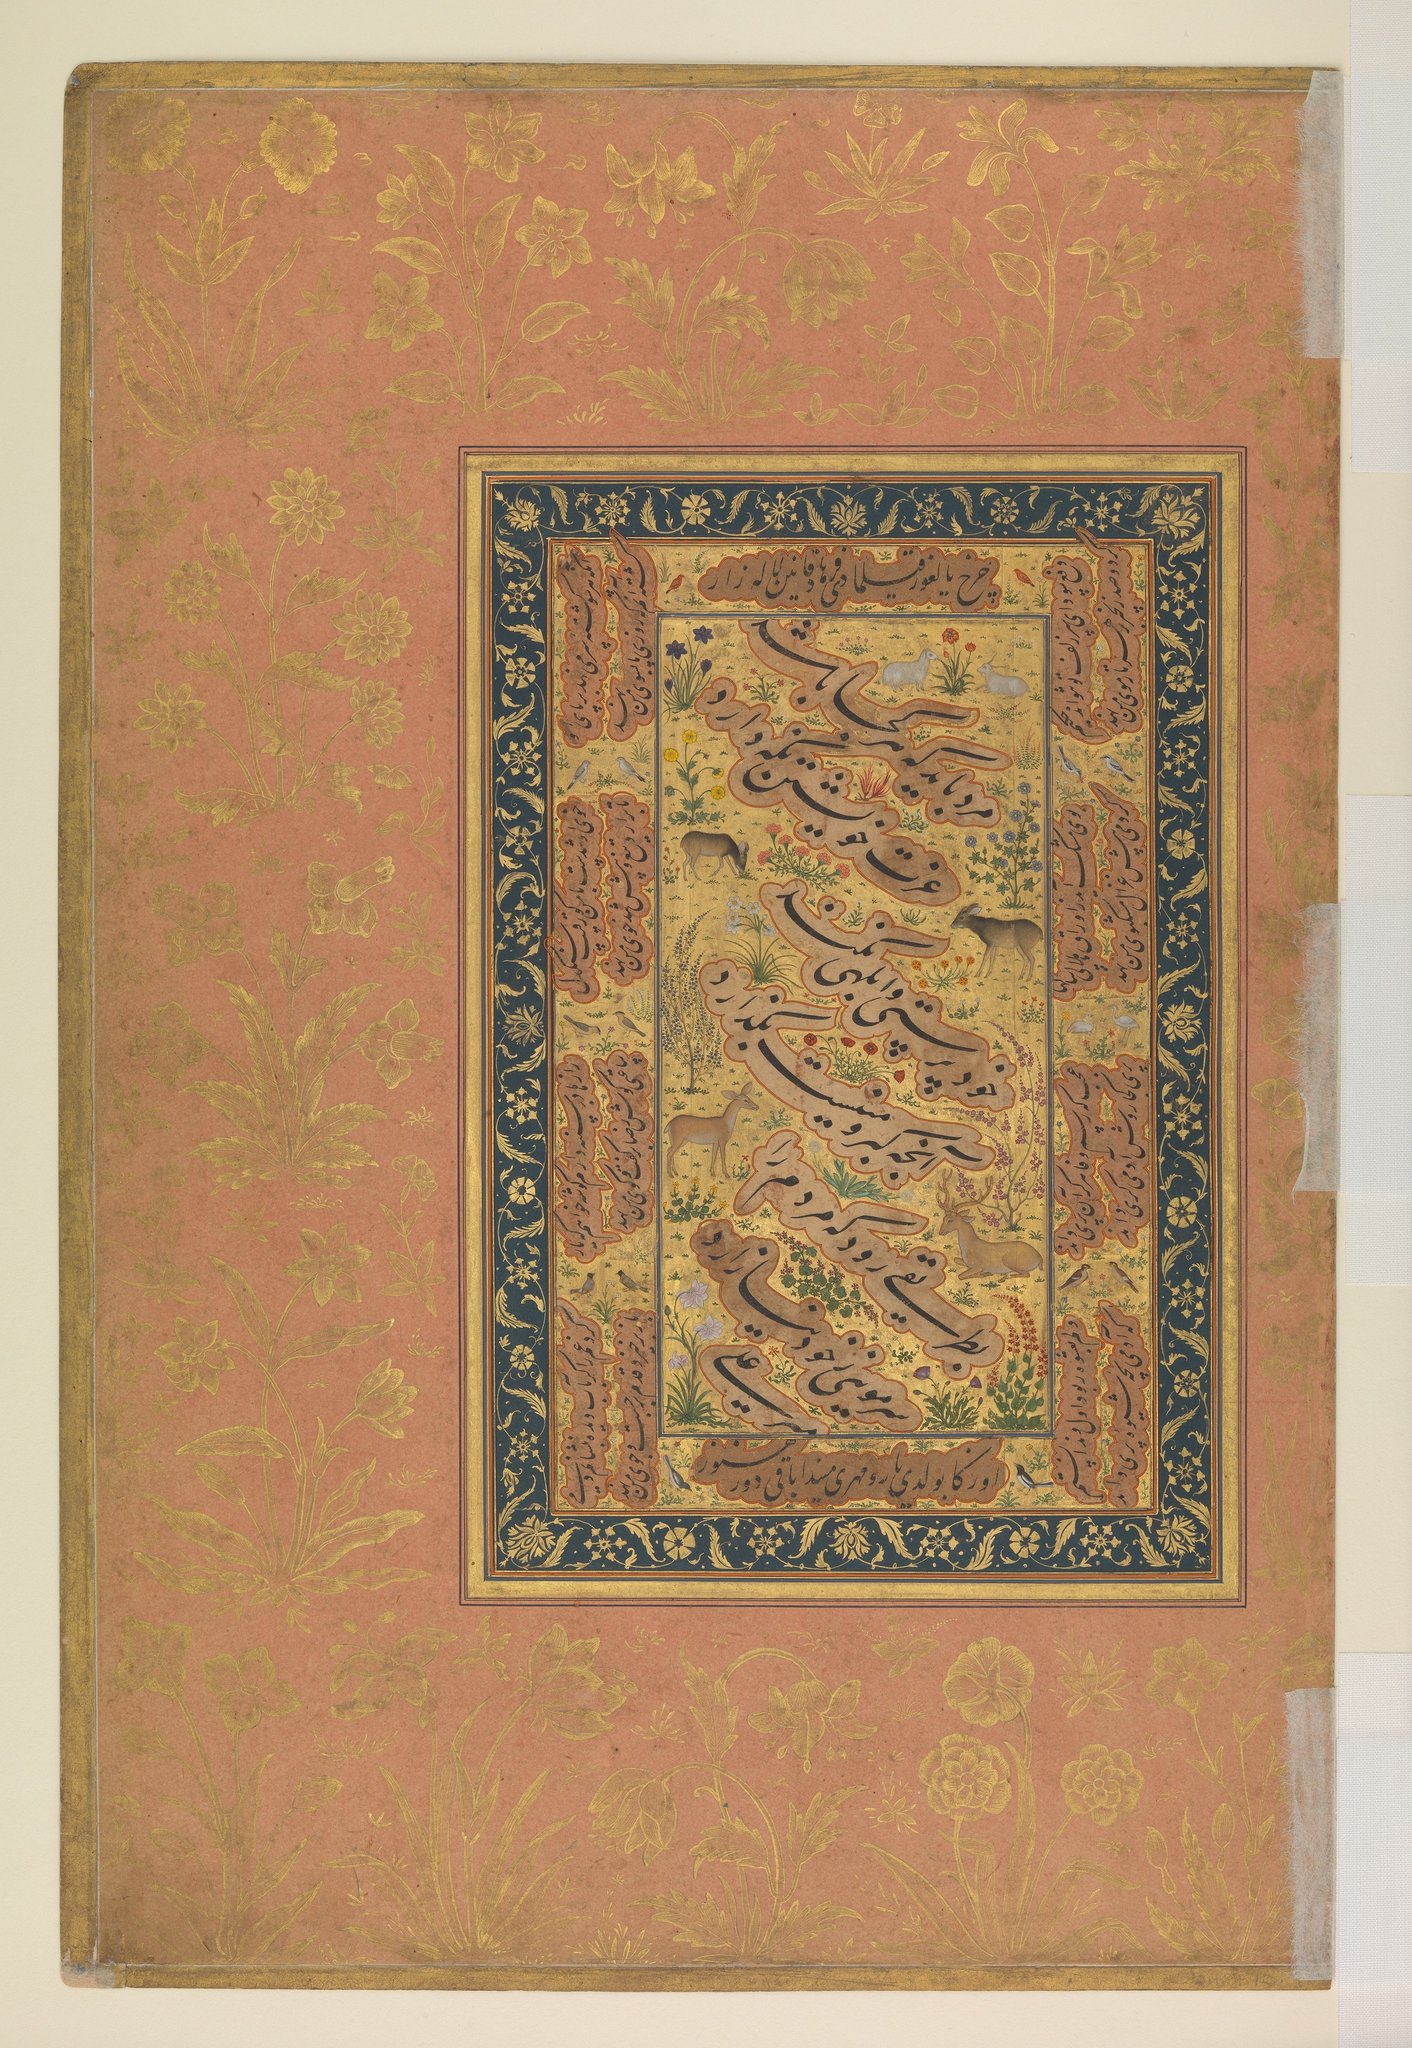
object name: album leaf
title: "Page of Calligraphy Illuminated with Animals and Plants in a Field of Flowers", Folio from the Shah Jahan Album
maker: nanha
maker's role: artist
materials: gold, ink, paper, watercolor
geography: india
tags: persian,deer,flowers,calligraphy